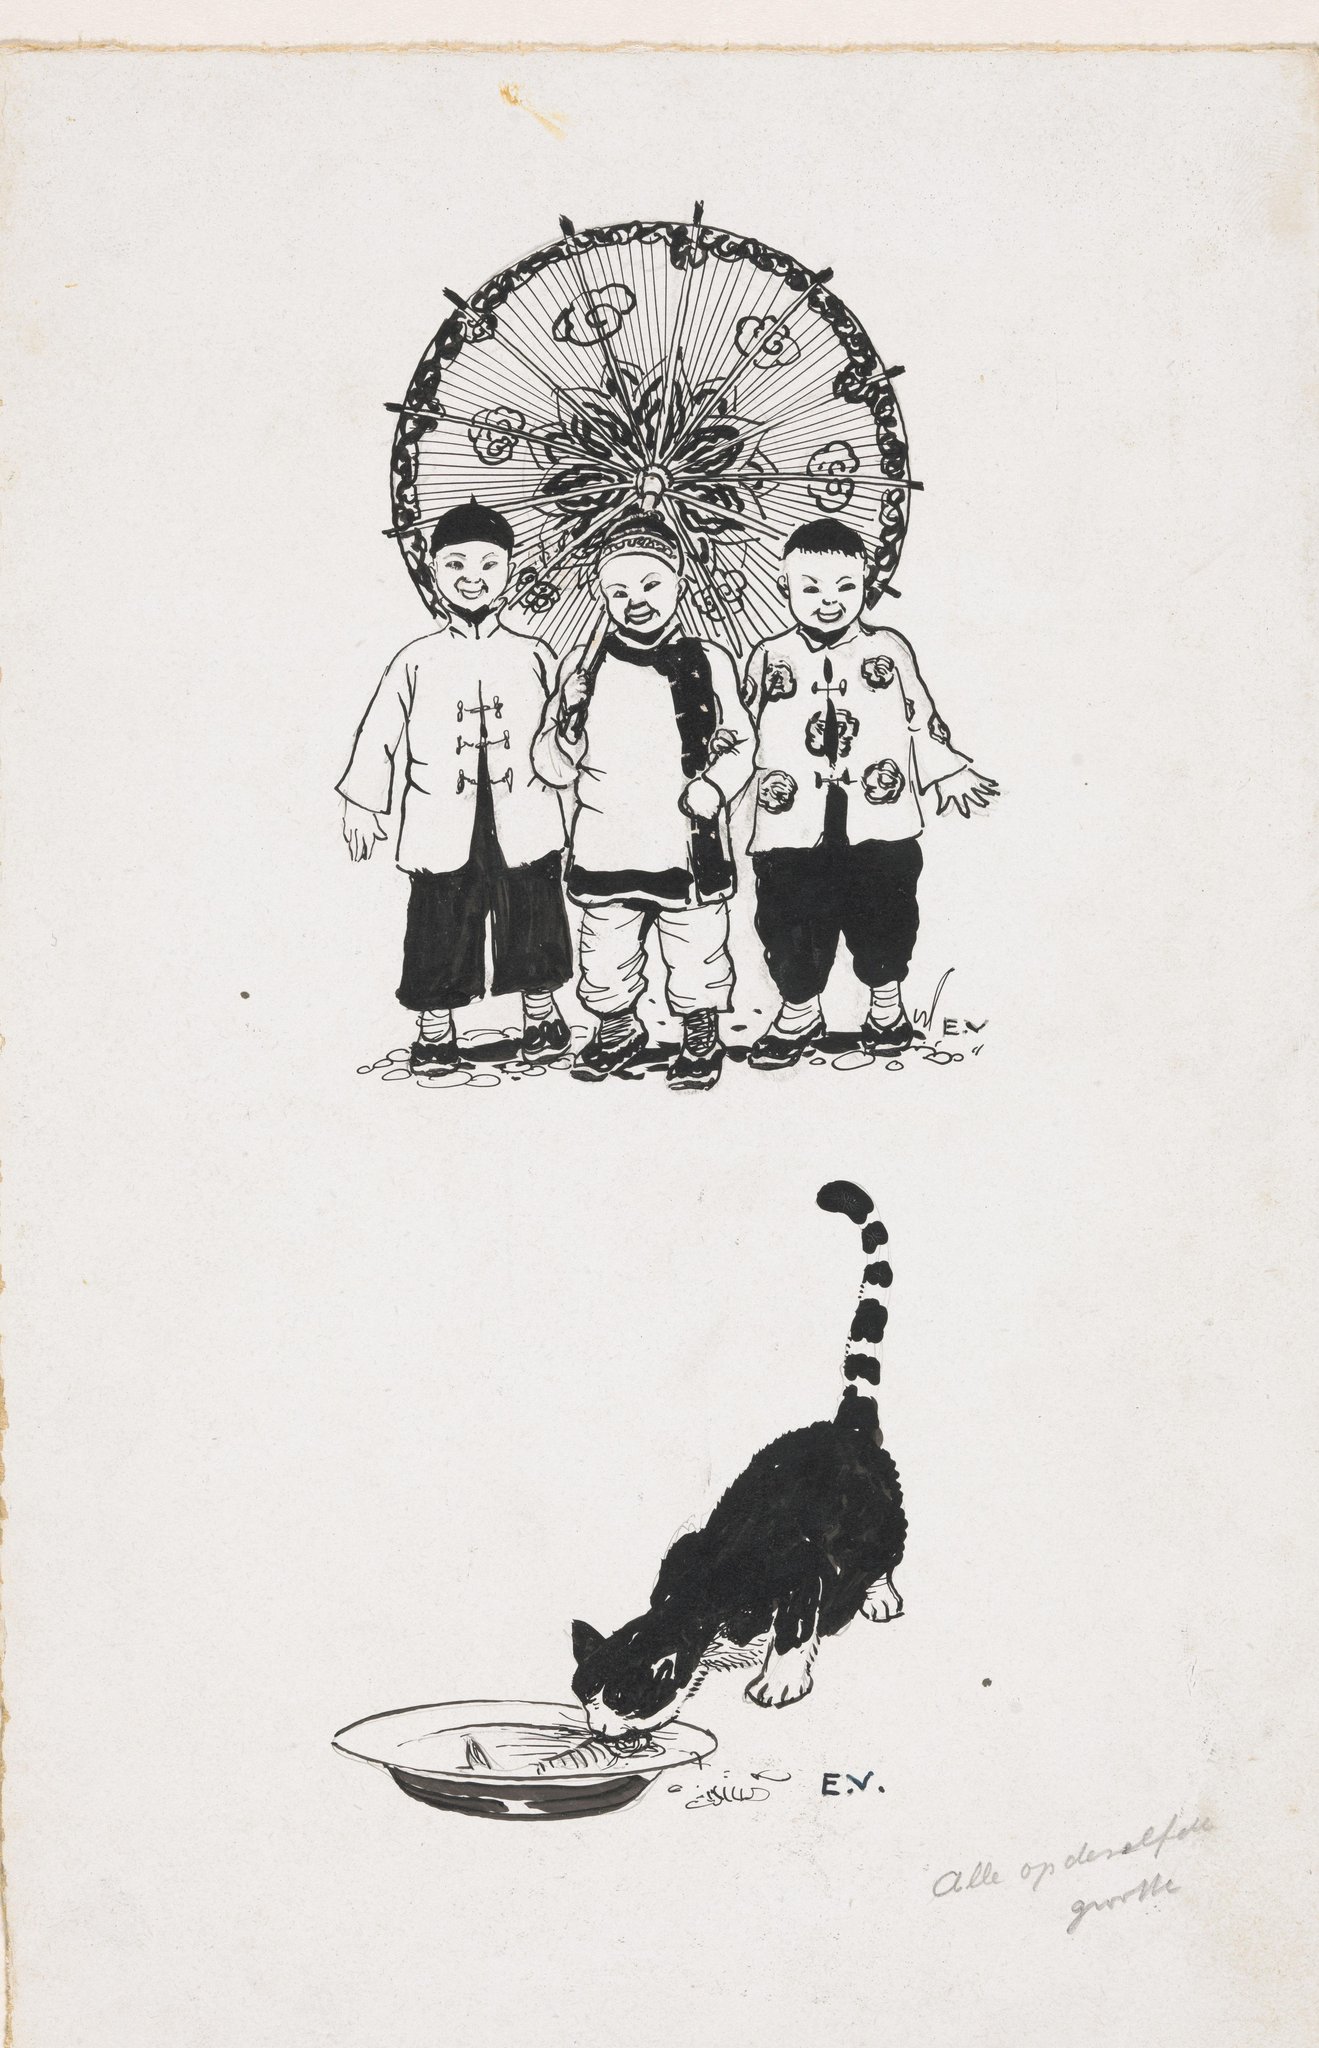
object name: boekillustratie ontwerp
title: Drie Chinese jongens en een etende kat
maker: elly verstijnen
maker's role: draughtsman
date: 1900-1930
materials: ink, paper, pencil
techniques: brush, pen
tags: chinese, cat, parasol, sunshade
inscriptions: :, collector's mark: Lugt 2228, signature: ‘E.V./ E.V.’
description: Drie lachende Chinese jongens staan op een rij. De middelste jongen houdt een parasol vast. Onder een kat die aan een bord snuffelt waarop een vis ligt.